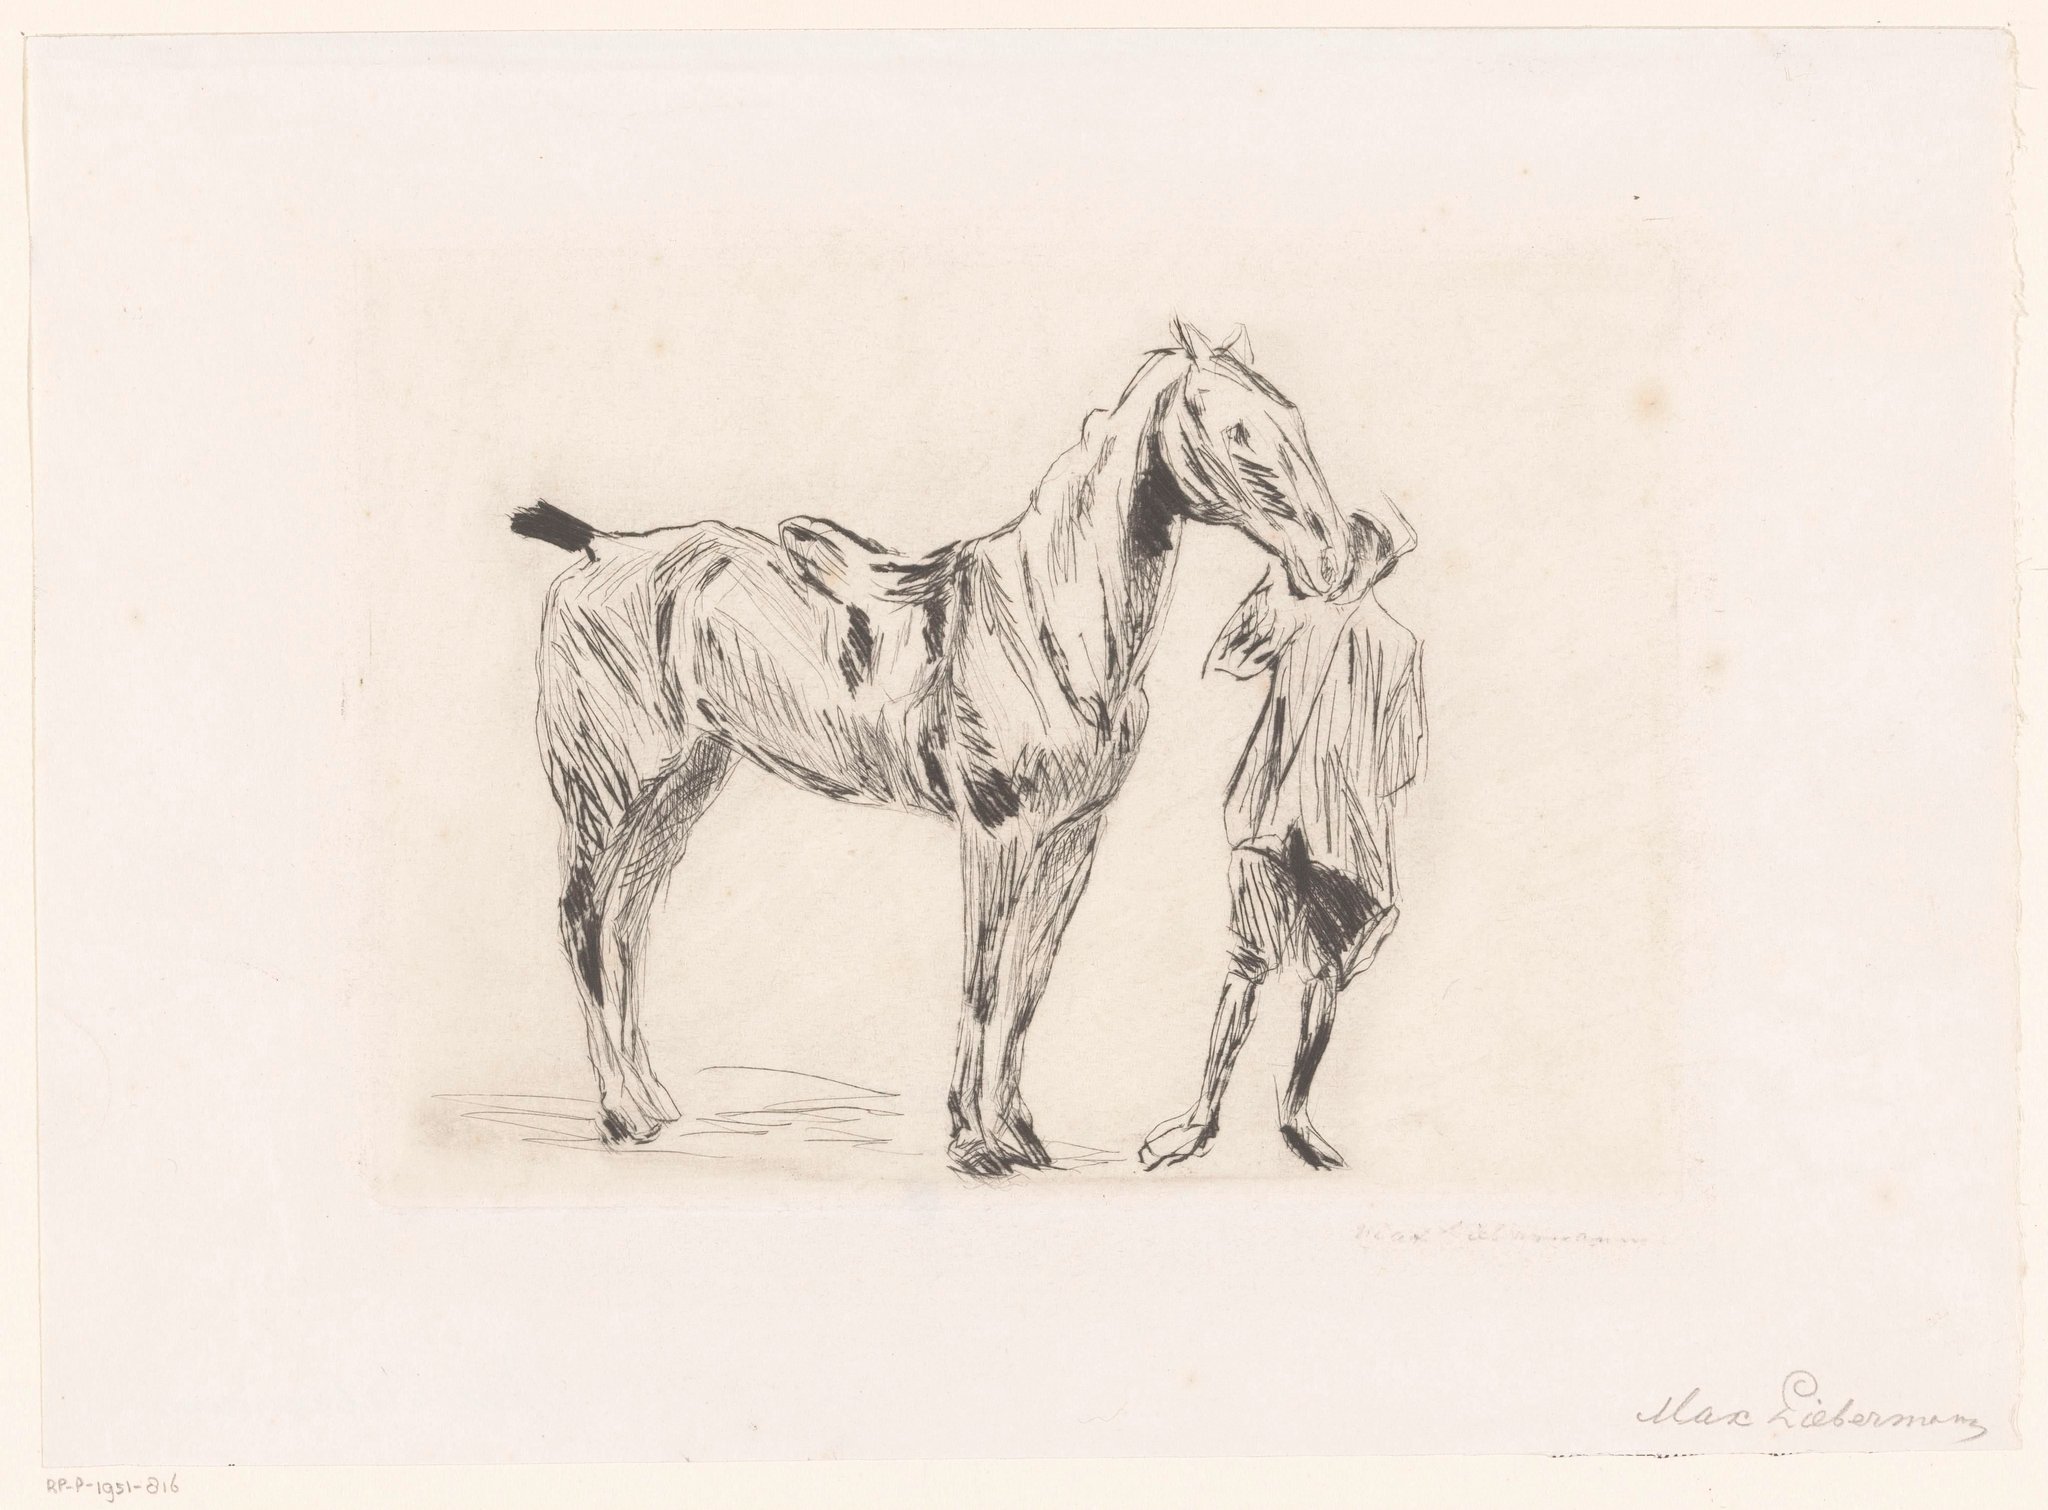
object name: print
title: Man met rijpaard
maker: max liebermann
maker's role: draughtsman, print maker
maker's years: 1847-1935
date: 1857-1935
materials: paper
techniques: drypoint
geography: berlin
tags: man and animal, horse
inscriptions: collector's mark: Lugt 2228, collector's mark: Lugt 2760